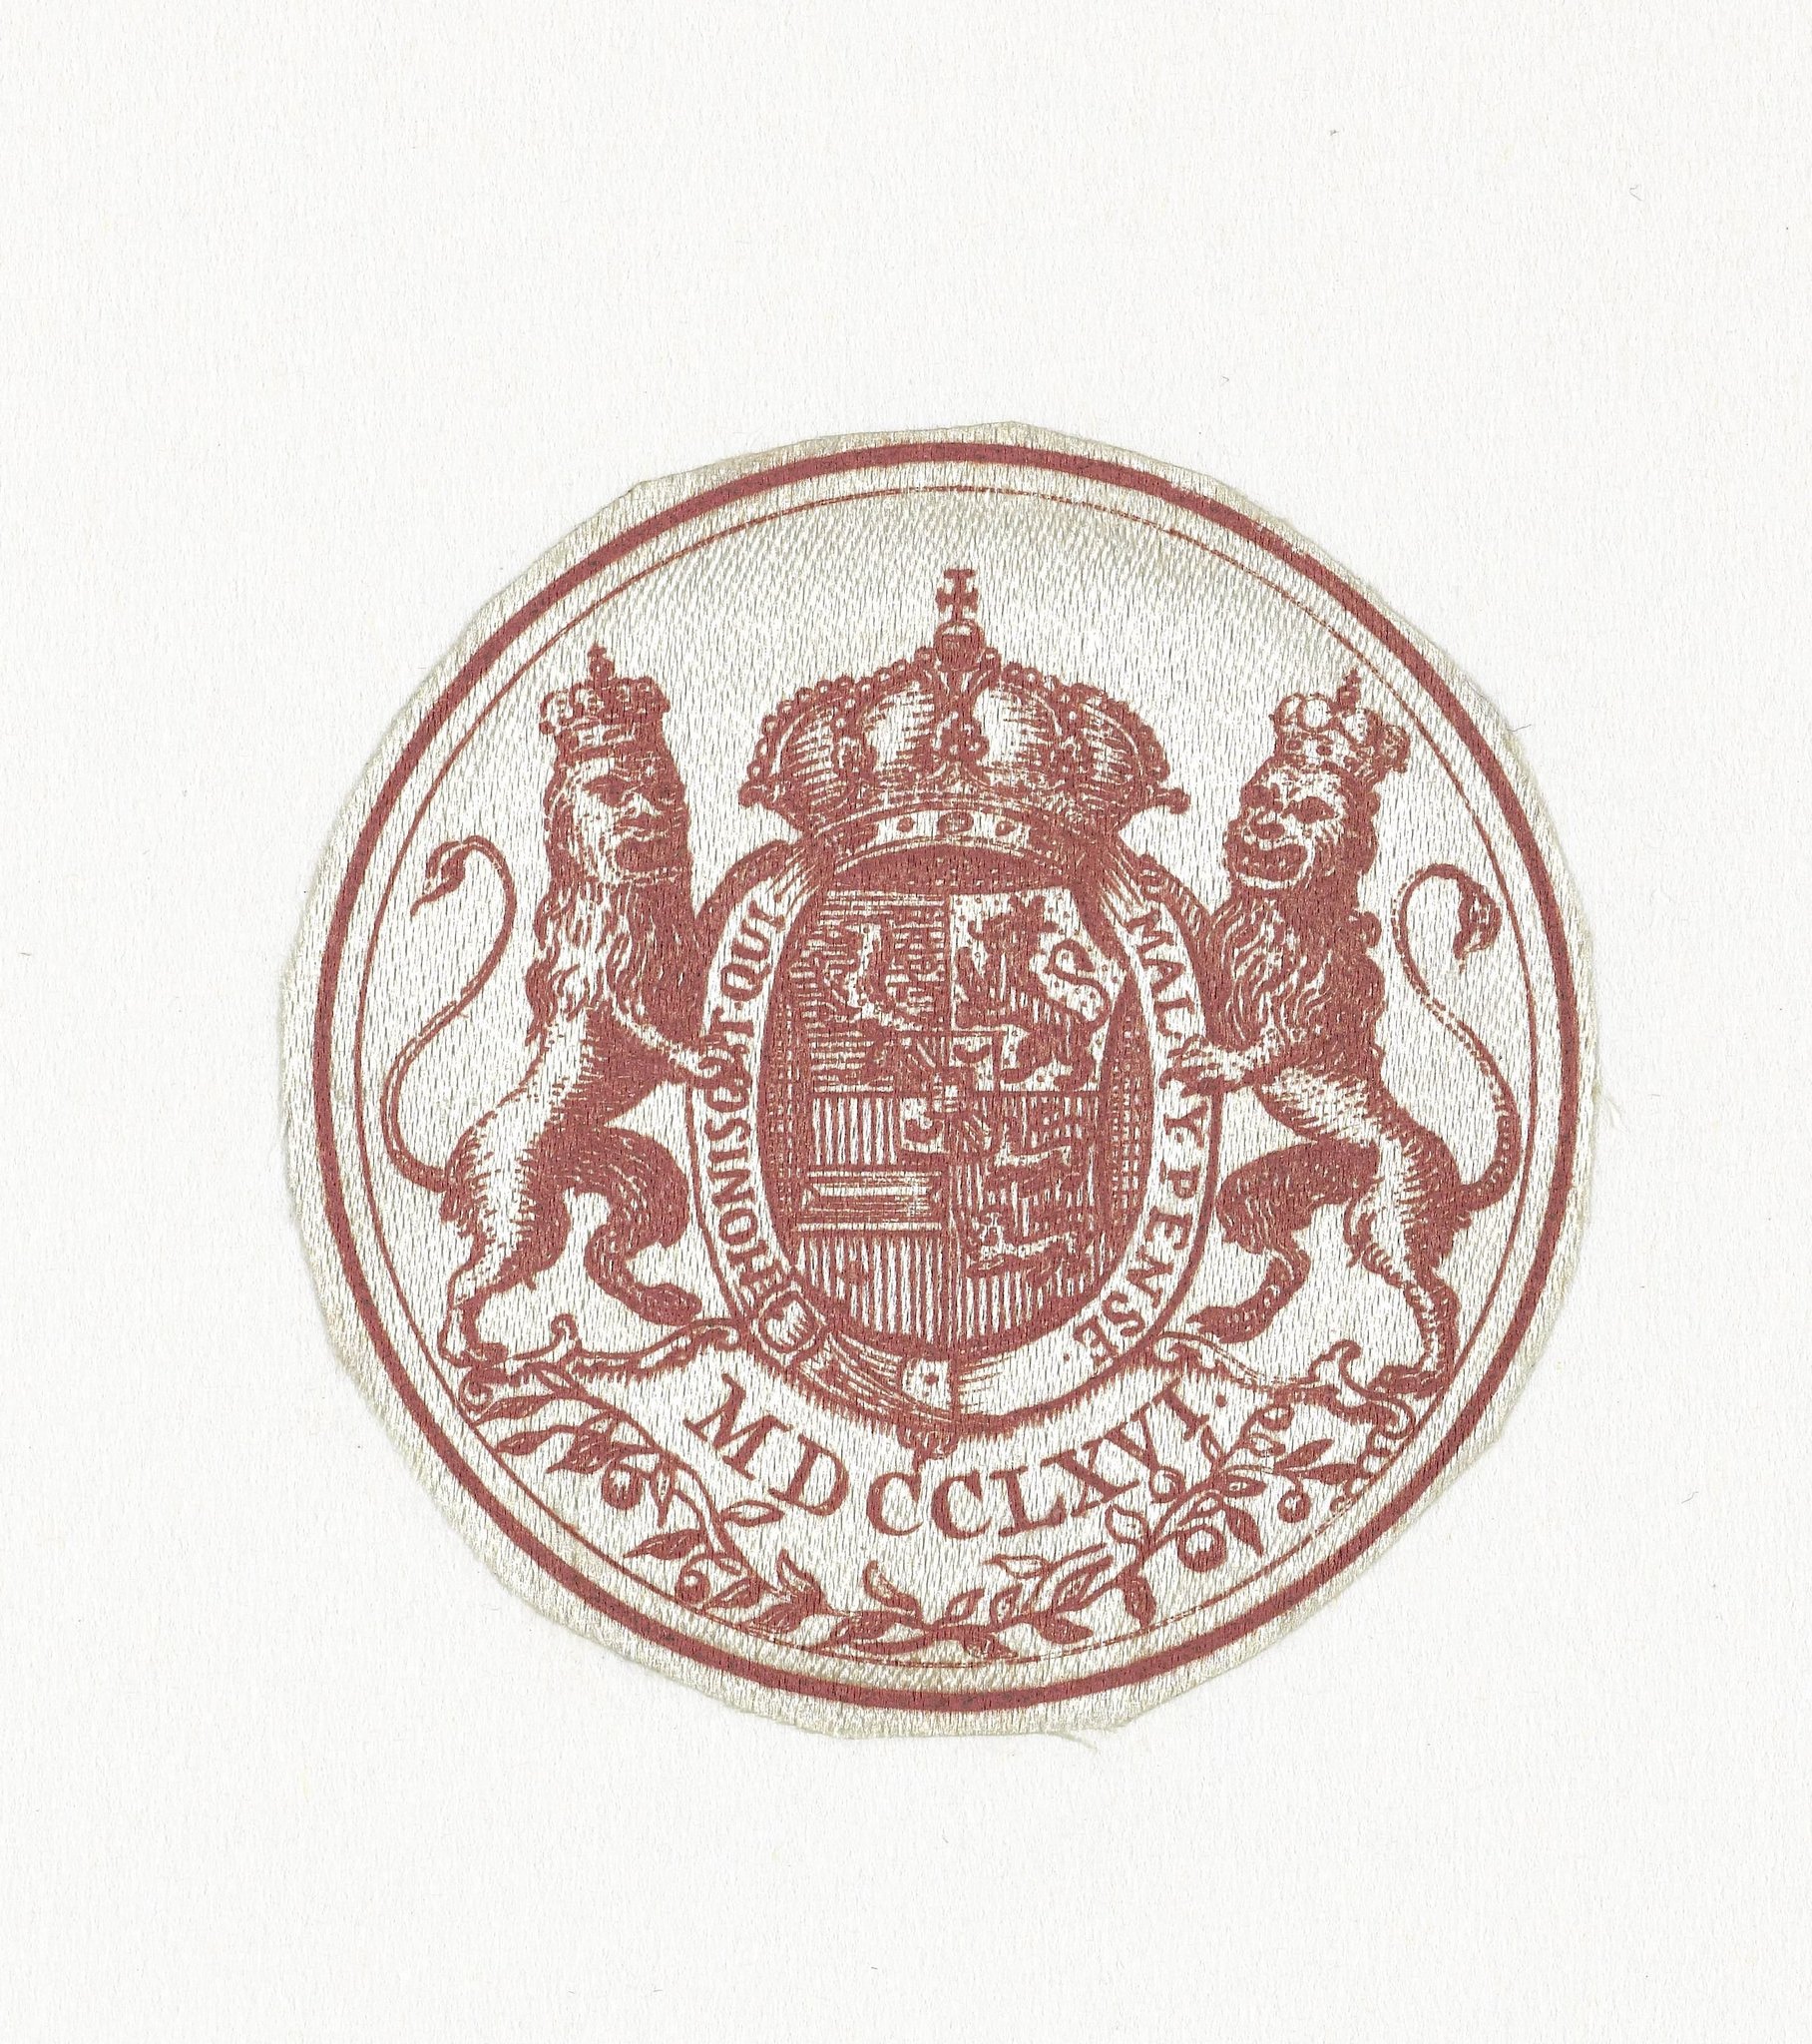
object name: print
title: Wapen van Engeland, variant van het type gedragen bij de verkiezing van Willem IV tot stadhouder, 1747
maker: Anonymous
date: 1766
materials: paper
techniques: etching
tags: the hague, willem iv (prins van oranje-nassau), insignia and symbols of sovereignty (crown, diadem, sceptre, orb, seal, standard, cloak, pectoral), great britain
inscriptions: collector's mark: Lugt 2228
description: Het wapen van Engeland, variant van het type zoals werd het gedragen in een kokarde op de hoed bij de verkiezing van Willem IV tot stadhouder, mei 1747. Uitgeknipt en op een stuk papier geplakt met opschrift. Dit exemplaar echter met het jaartal 1766.